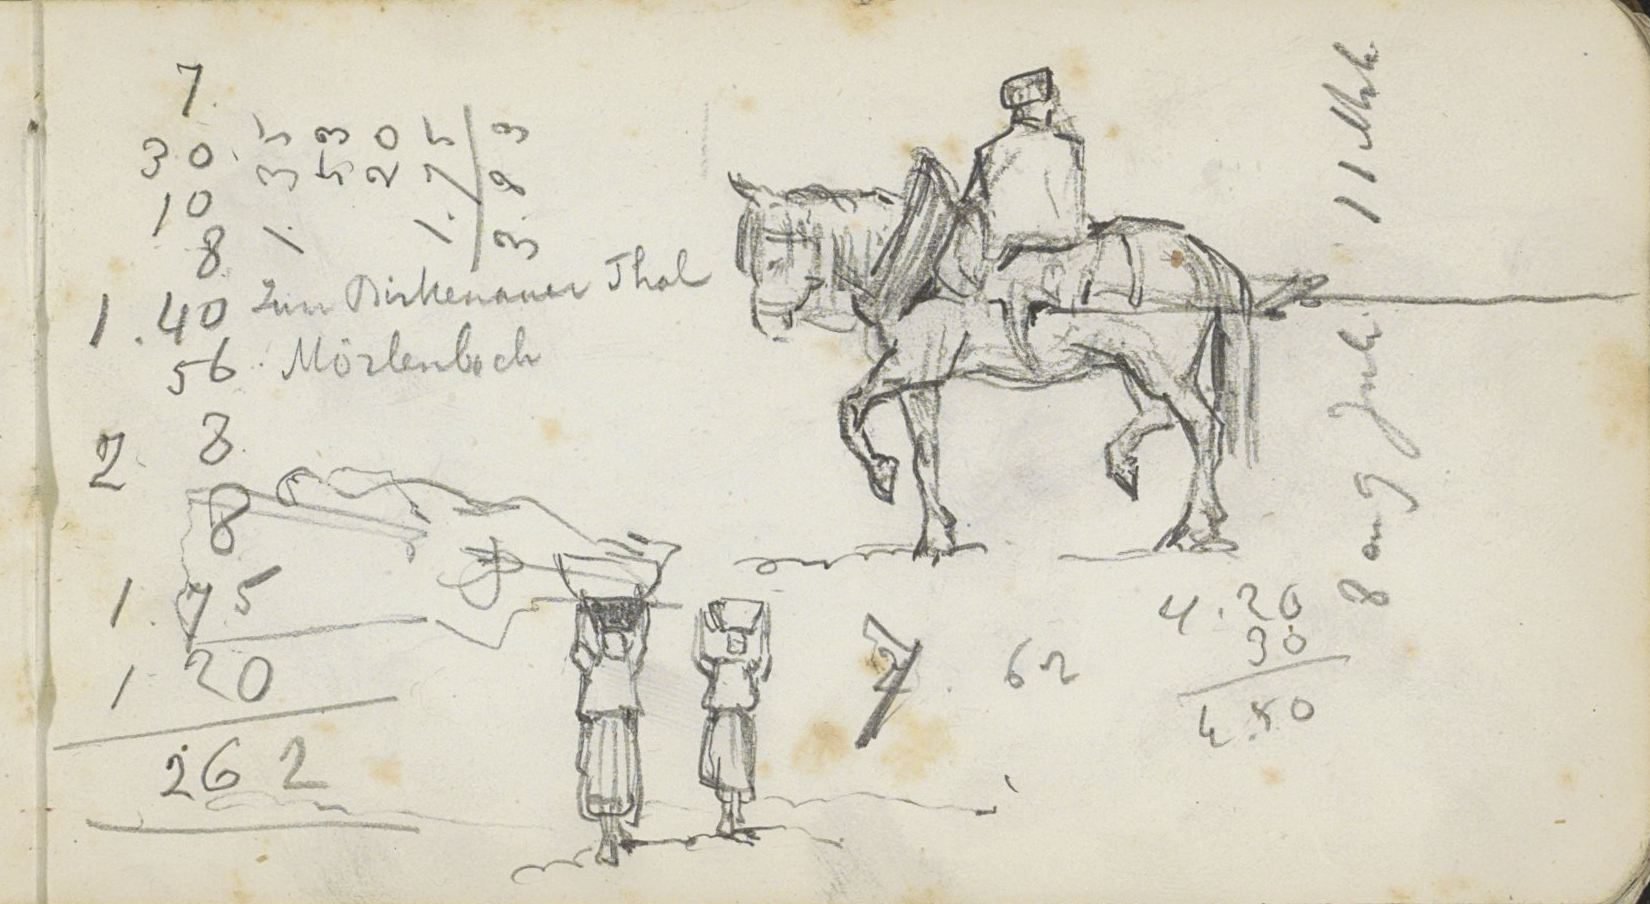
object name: sketchbook leaf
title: Ruiter en vrouwen met schalen op het hoofd te Mörlenbach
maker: geo poggenbeek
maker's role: draughtsman, painter, print maker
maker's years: 1853-1903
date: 1807-1876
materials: paper, pencil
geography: mörlenbach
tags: riding a horse, ass, or mule; rider, horseman, landscapes (+ landscape with figures, staffage), carrying something on the head or on the shoulders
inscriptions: date and inscription: ‘Zum Dinkenauer Thal/ Mörlenbach/ 8 en 9 juli ...’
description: Blad 6 recto uit een schetsboek met 69 bladen.